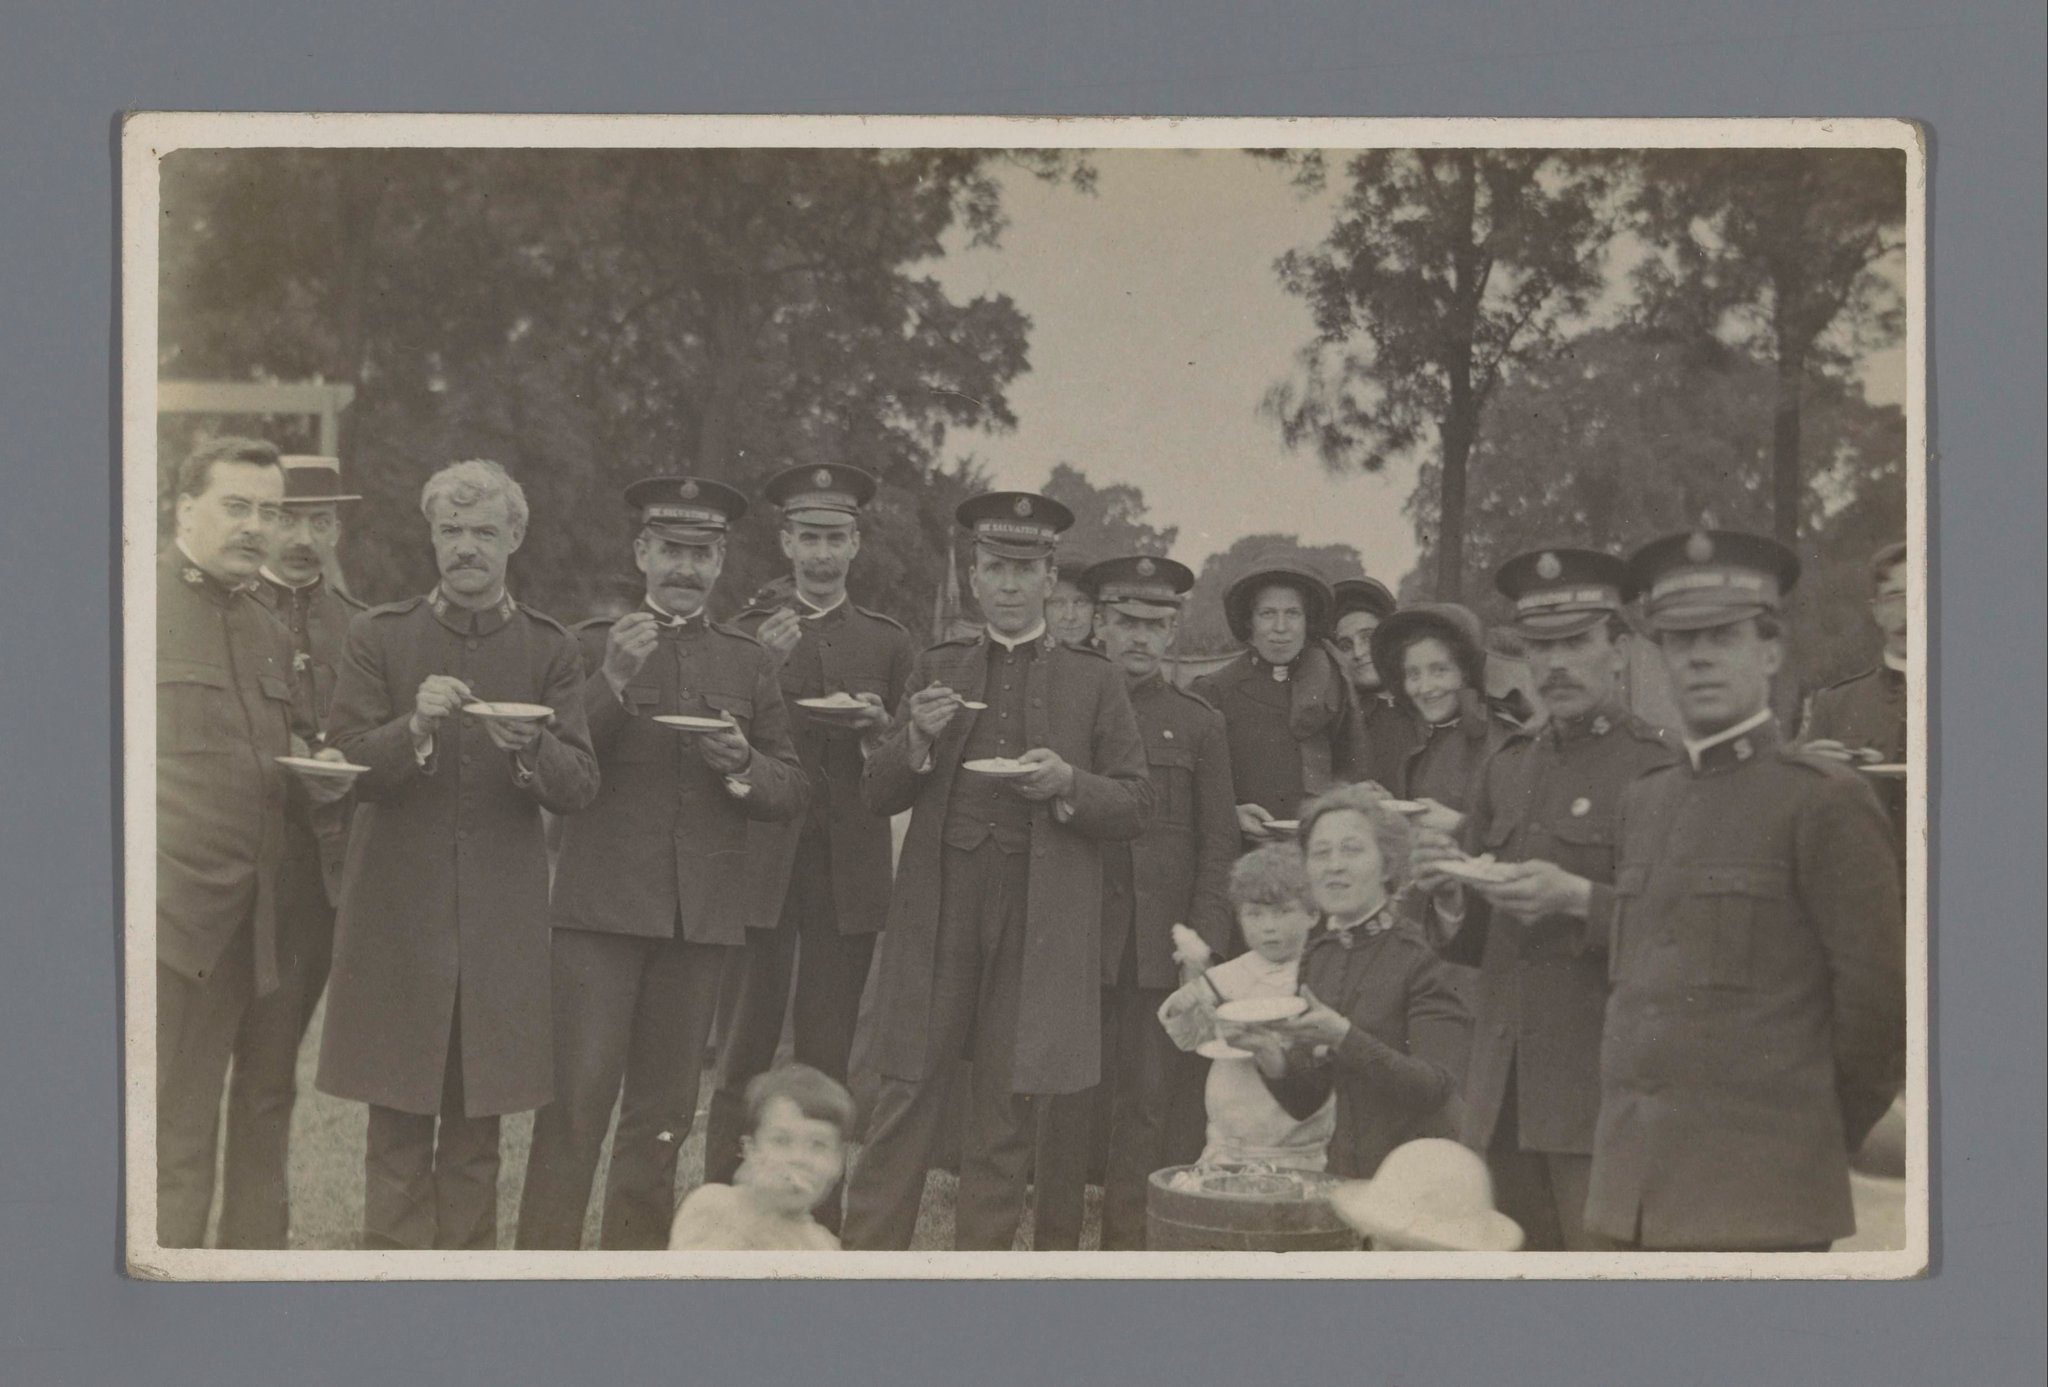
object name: photograph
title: Groepsportret van leden van het Leger des Heils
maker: Anonymous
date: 1907-1913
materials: photographic support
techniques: gelatin silver print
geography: great britain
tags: functionaries and dignitaries in the salvation army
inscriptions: inscription: ‘L. O? aut[...] East[...] July 13’